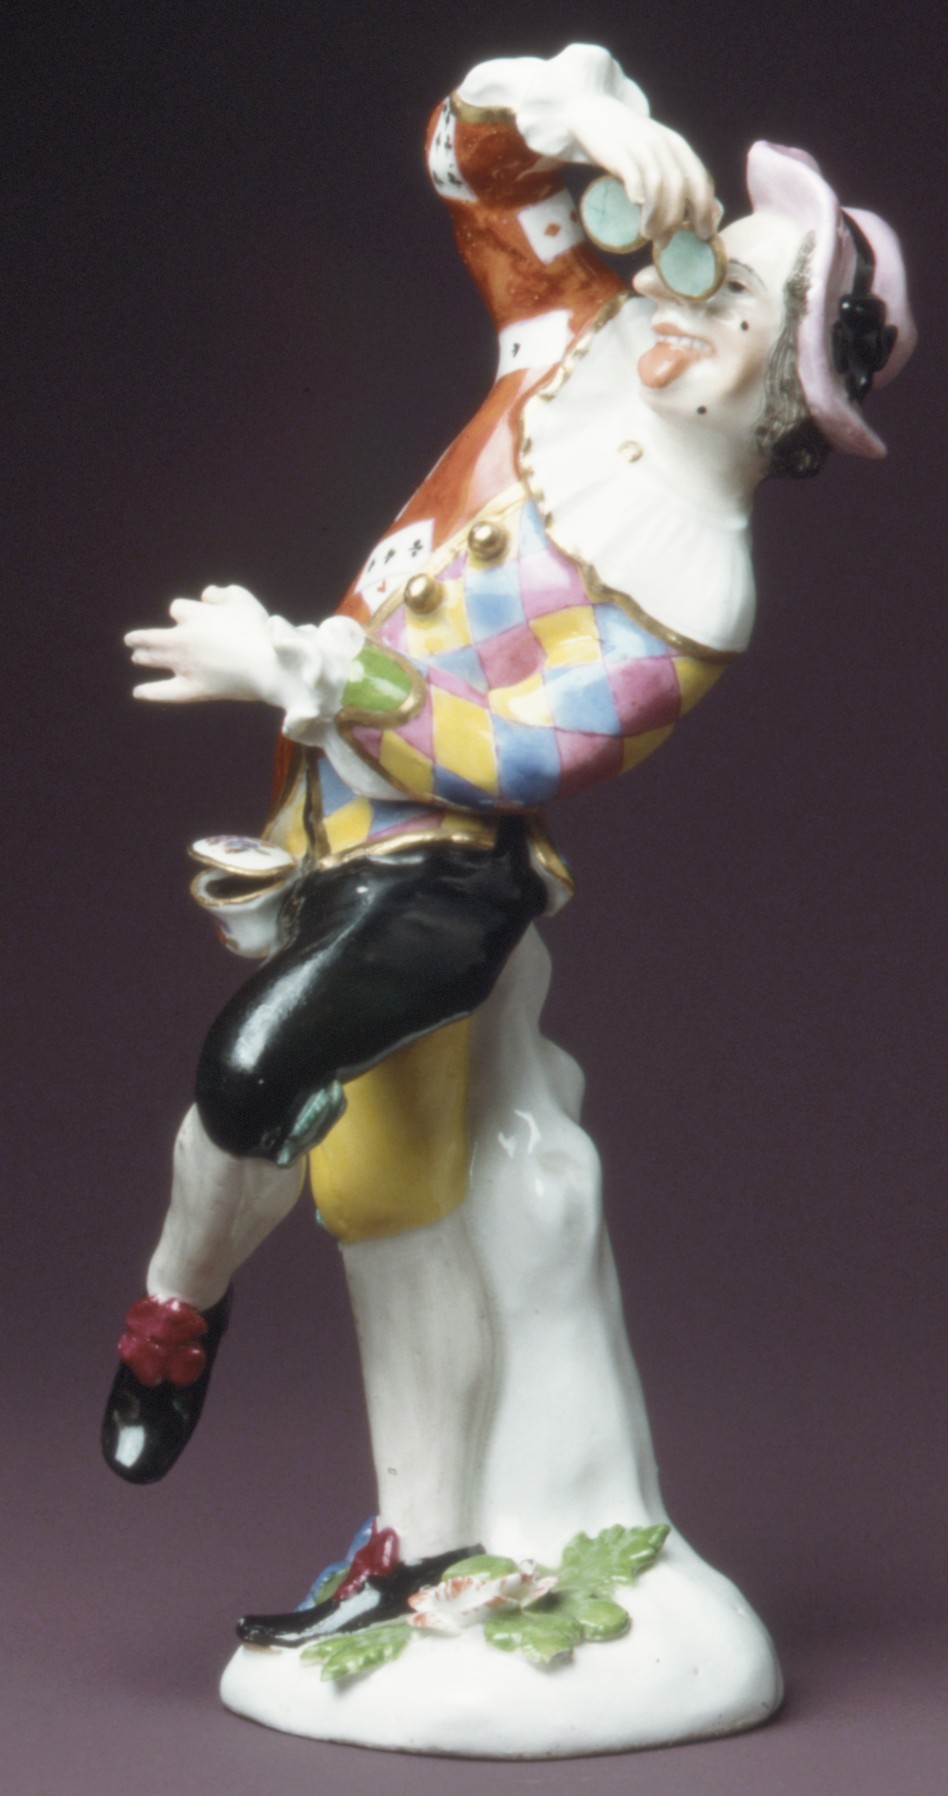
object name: figure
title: Harlequin with pince-nez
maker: meissen manufactory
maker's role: manufactory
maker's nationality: german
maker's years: 1710-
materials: hard paste porcelain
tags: men